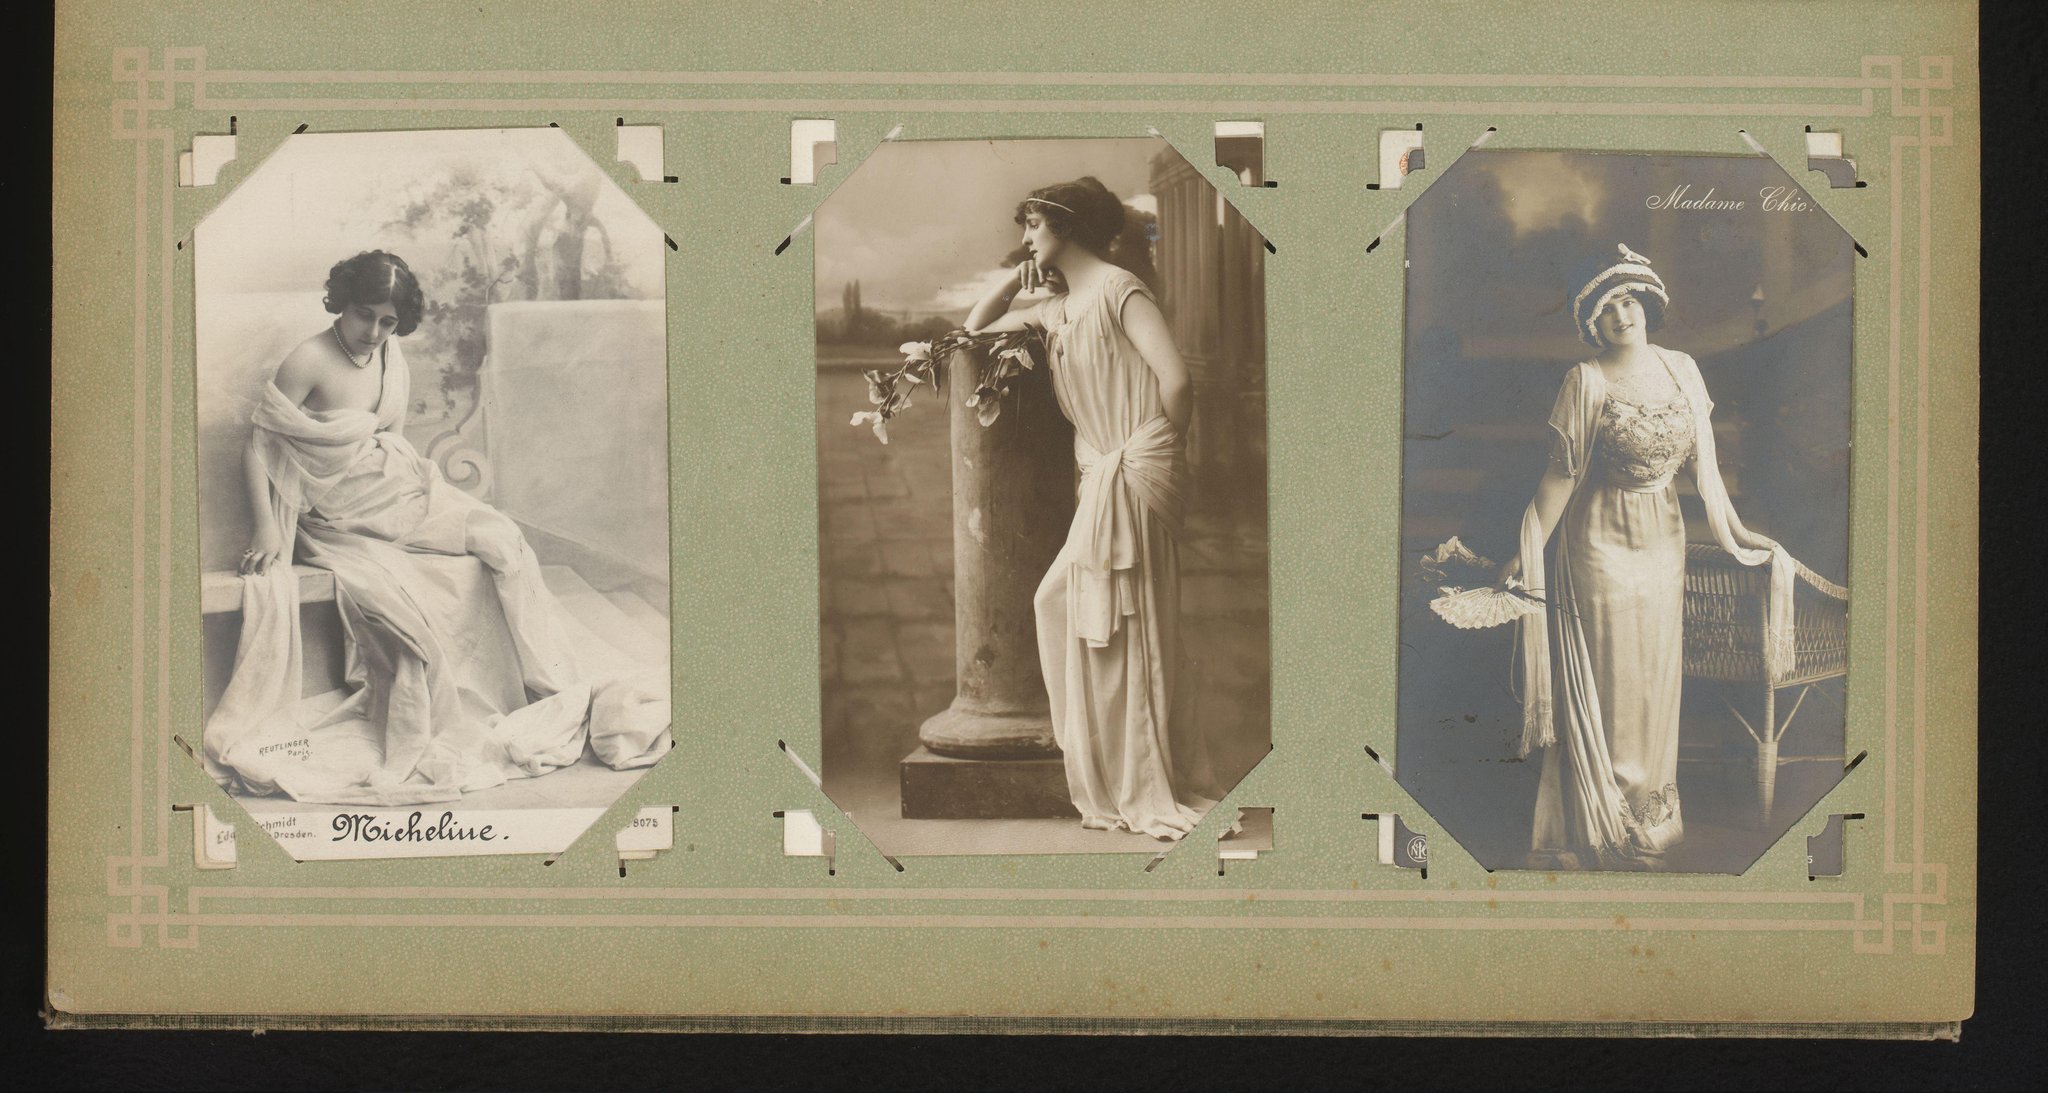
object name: ansichtkaart, prentbriefkaart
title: Drie portretten van actrices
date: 1900-1930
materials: cardboard, photographic support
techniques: gelatin silver print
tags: historical persons - bb - woman, portrait of actor, actress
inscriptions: monogram: ‘GLCo’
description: Deze foto's maken deel uit van een album.